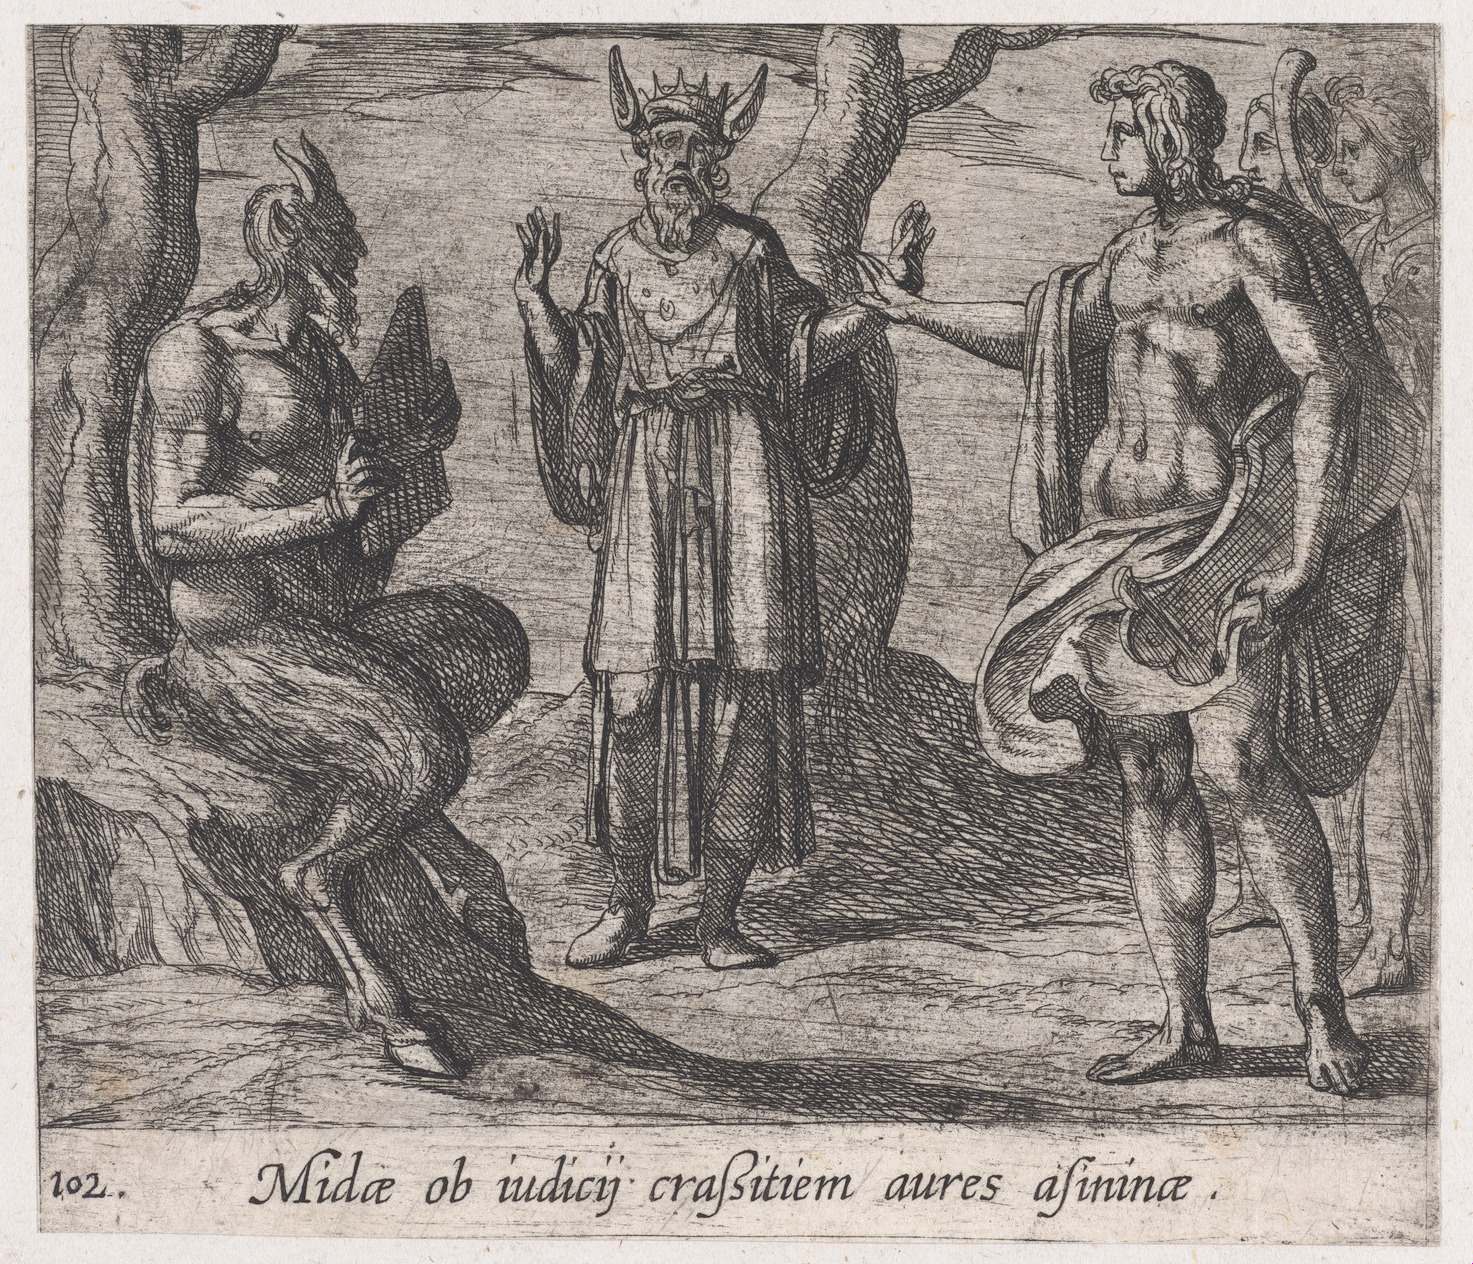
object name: print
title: Plate 102: Midas with the Ears of an Ass (Midae ob iudicij craßustiem aures asininae), from Ovid's 'Metamorphoses'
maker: antonio tempesta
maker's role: artist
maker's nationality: italian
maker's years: 1555-1630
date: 1606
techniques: etching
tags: men,midas,satyrs